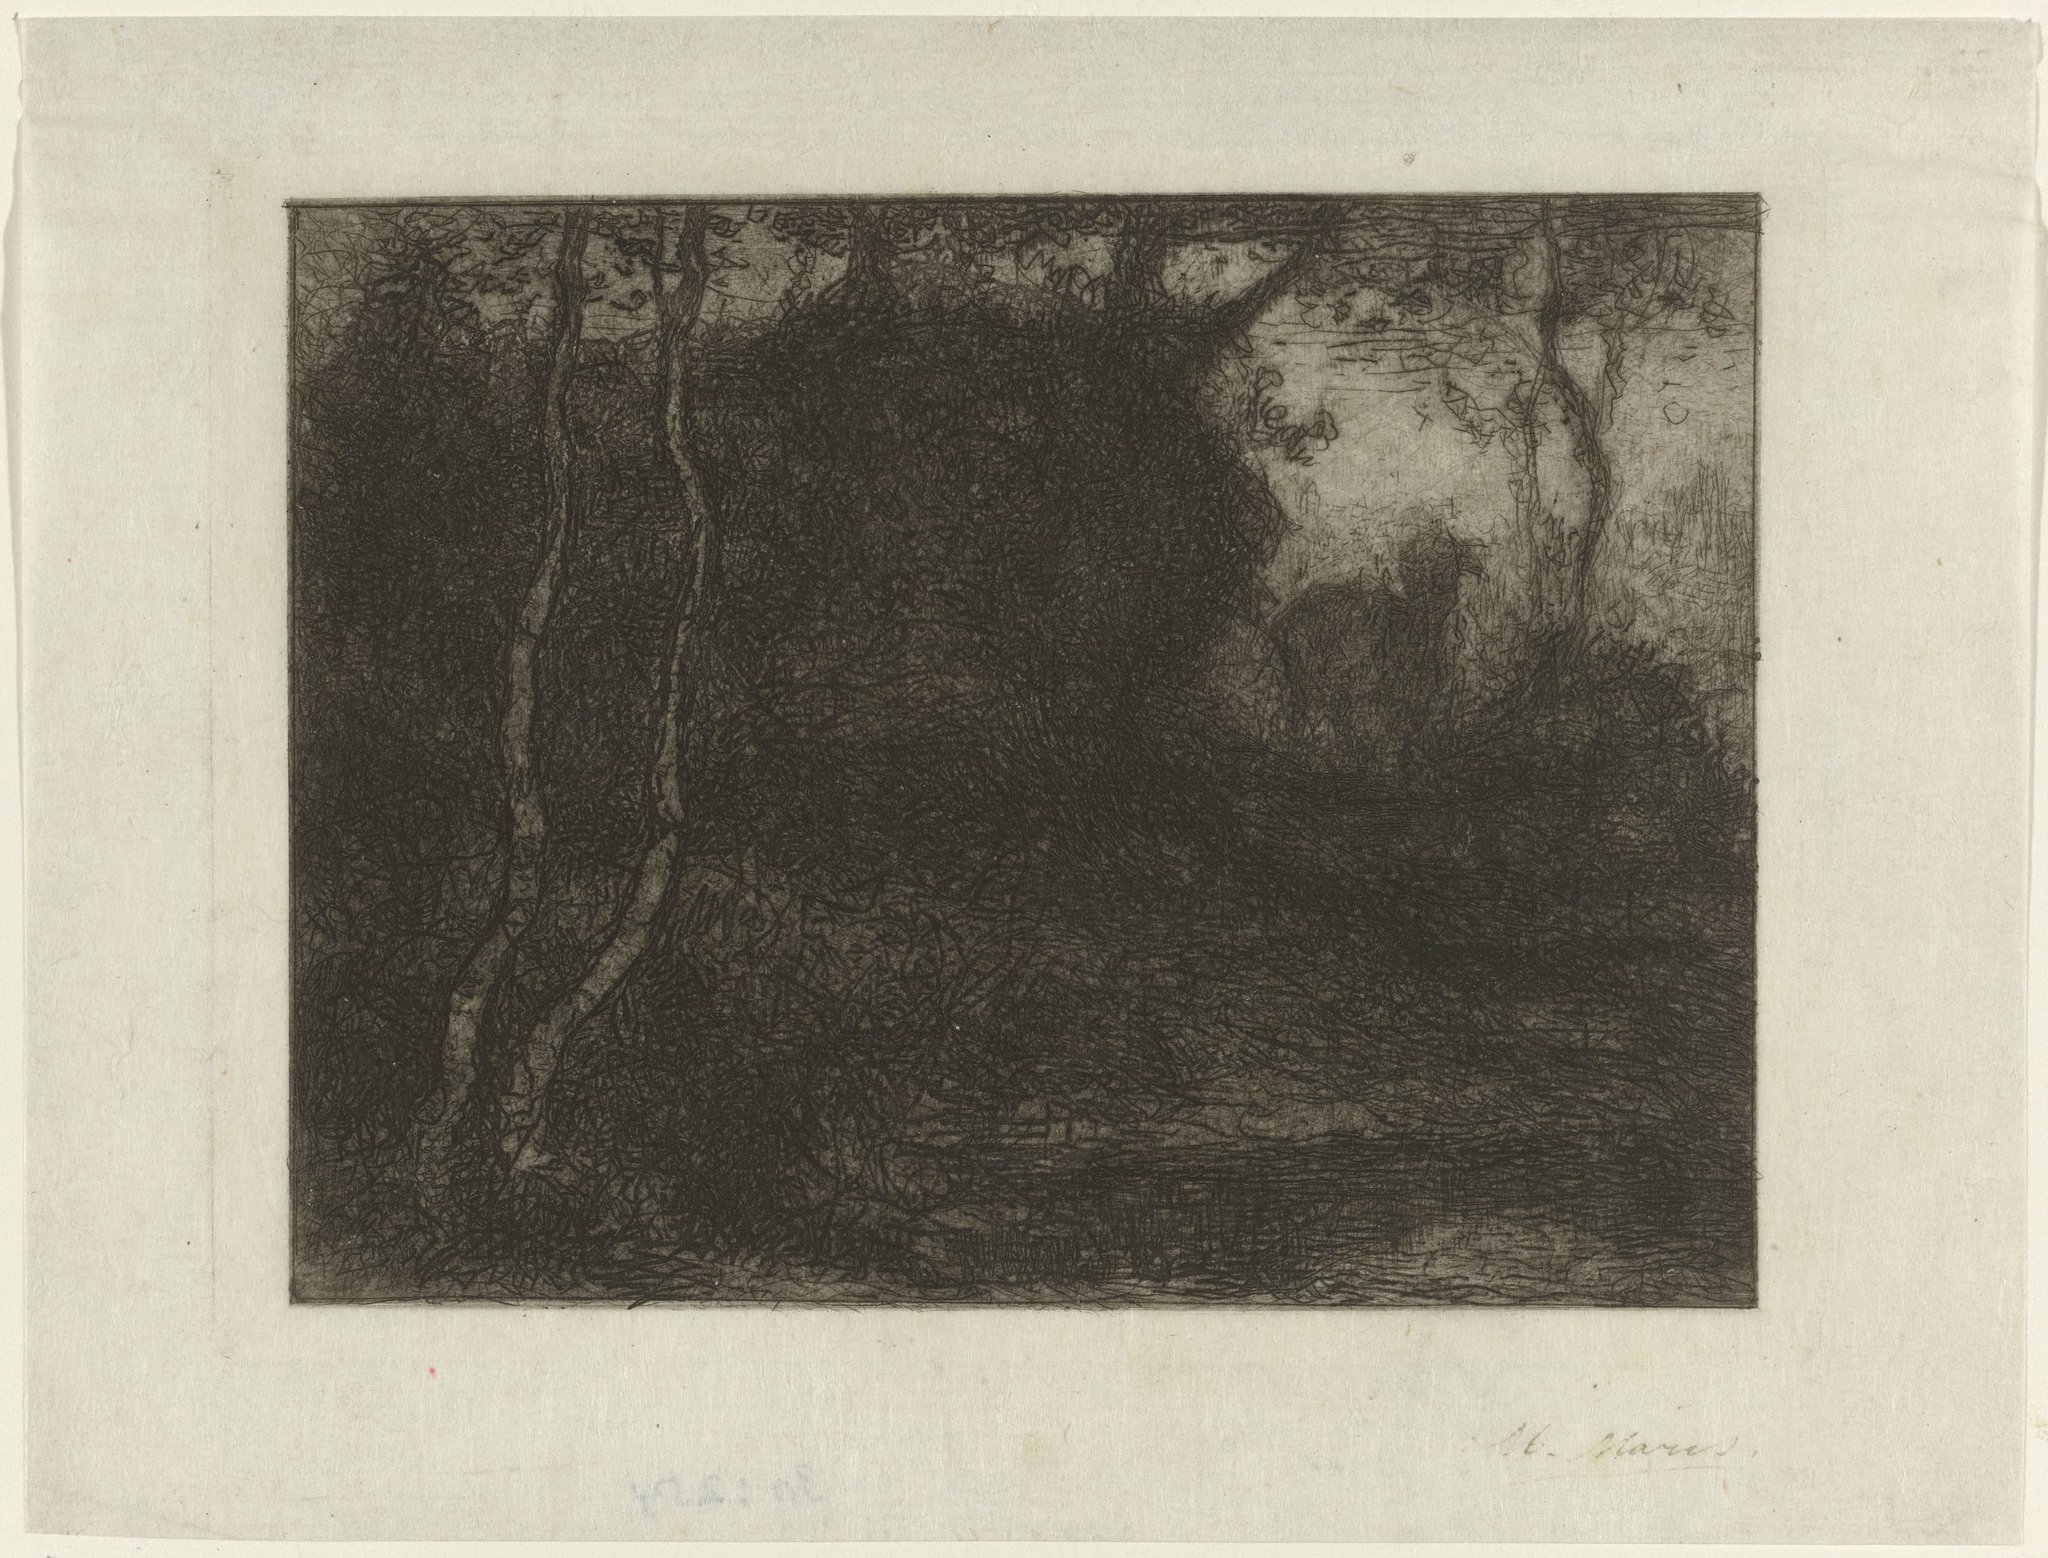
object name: print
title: Bos met geitje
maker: matthijs maris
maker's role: draughtsman, painter, print maker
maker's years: 1839-1917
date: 1883-1888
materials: paper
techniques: etching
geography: london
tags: trees, lamb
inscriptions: name: ‘M.Maris’, collector's mark: Lugt 2228